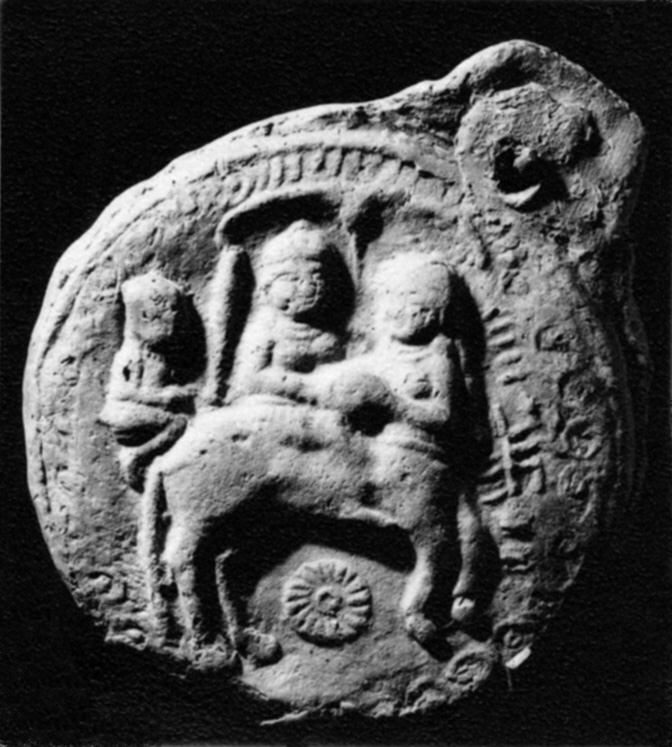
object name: rattle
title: Auspicious Emblem with Pururavas and Urvashi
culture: indian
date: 100 BCE-100 CE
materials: terracotta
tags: shunga,emblems